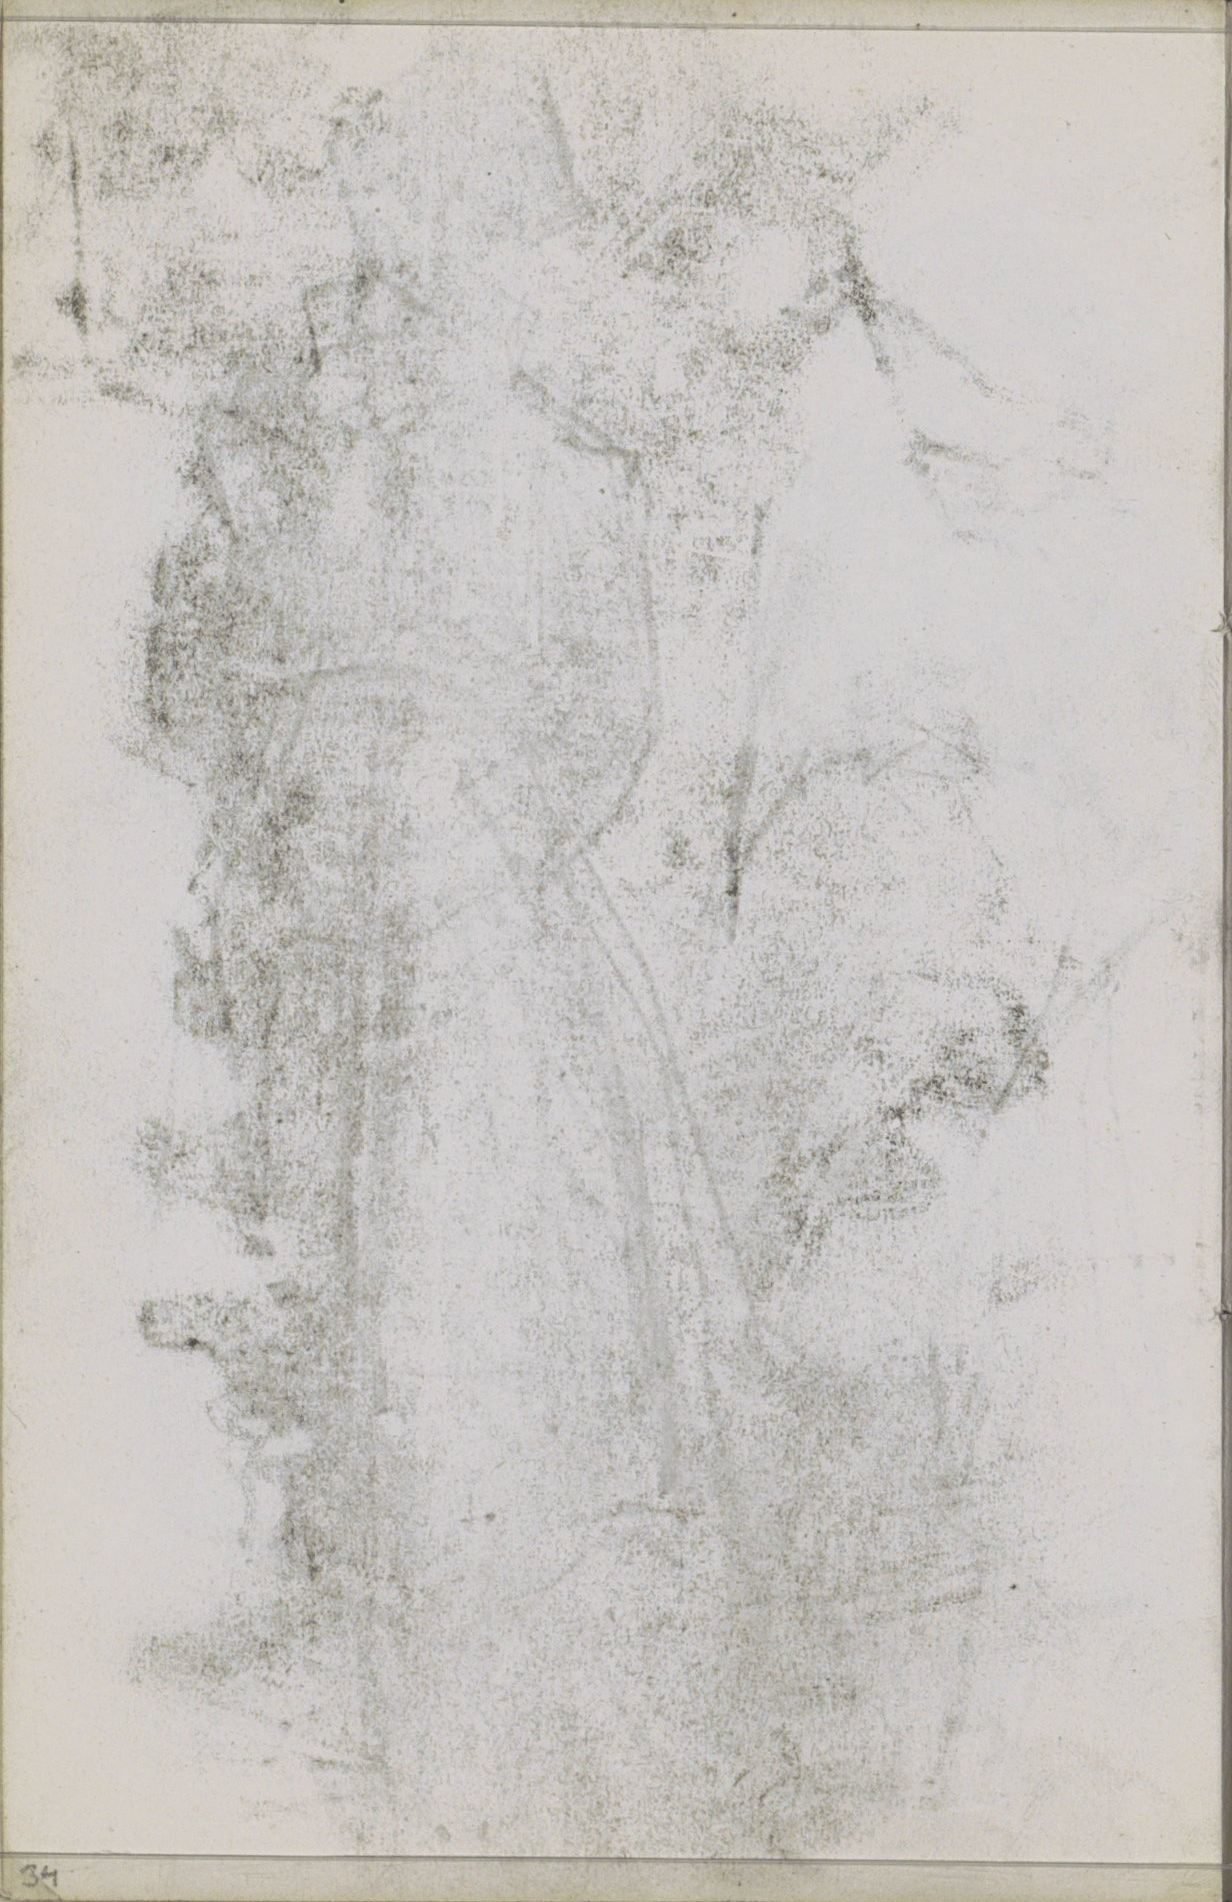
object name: sketchbook leaf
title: Abklatsch van de krijttekening op pagina 35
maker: isaac israels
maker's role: draughtsman, painter, print maker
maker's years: 1865-1934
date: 1875-1934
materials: paper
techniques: printmaking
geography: amsterdam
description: Pagina 34 uit schetsboek XXIX met 44 pagina's.